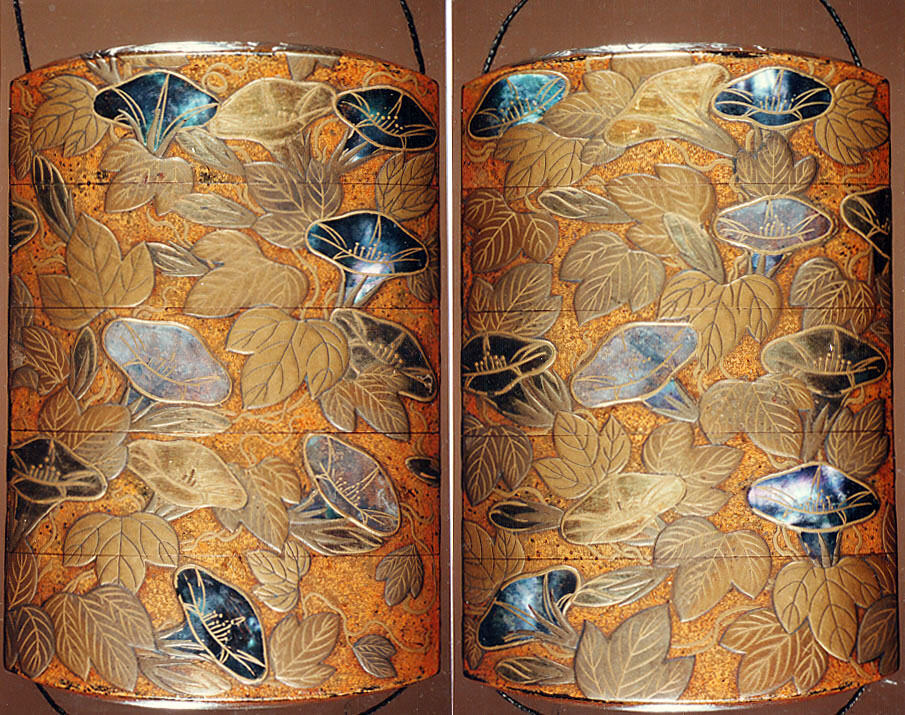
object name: inrō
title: Case (Inrō) with Design of Flowering Morning Glory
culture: japanese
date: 1801-1900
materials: gold, lacquer, silver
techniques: fundame, hiramakie, inlay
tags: flowers